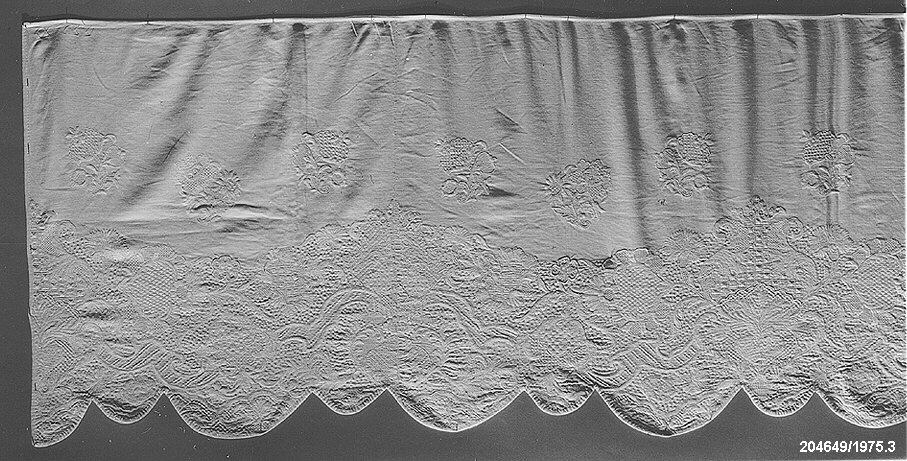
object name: valance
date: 1701-1800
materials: cotton, linen